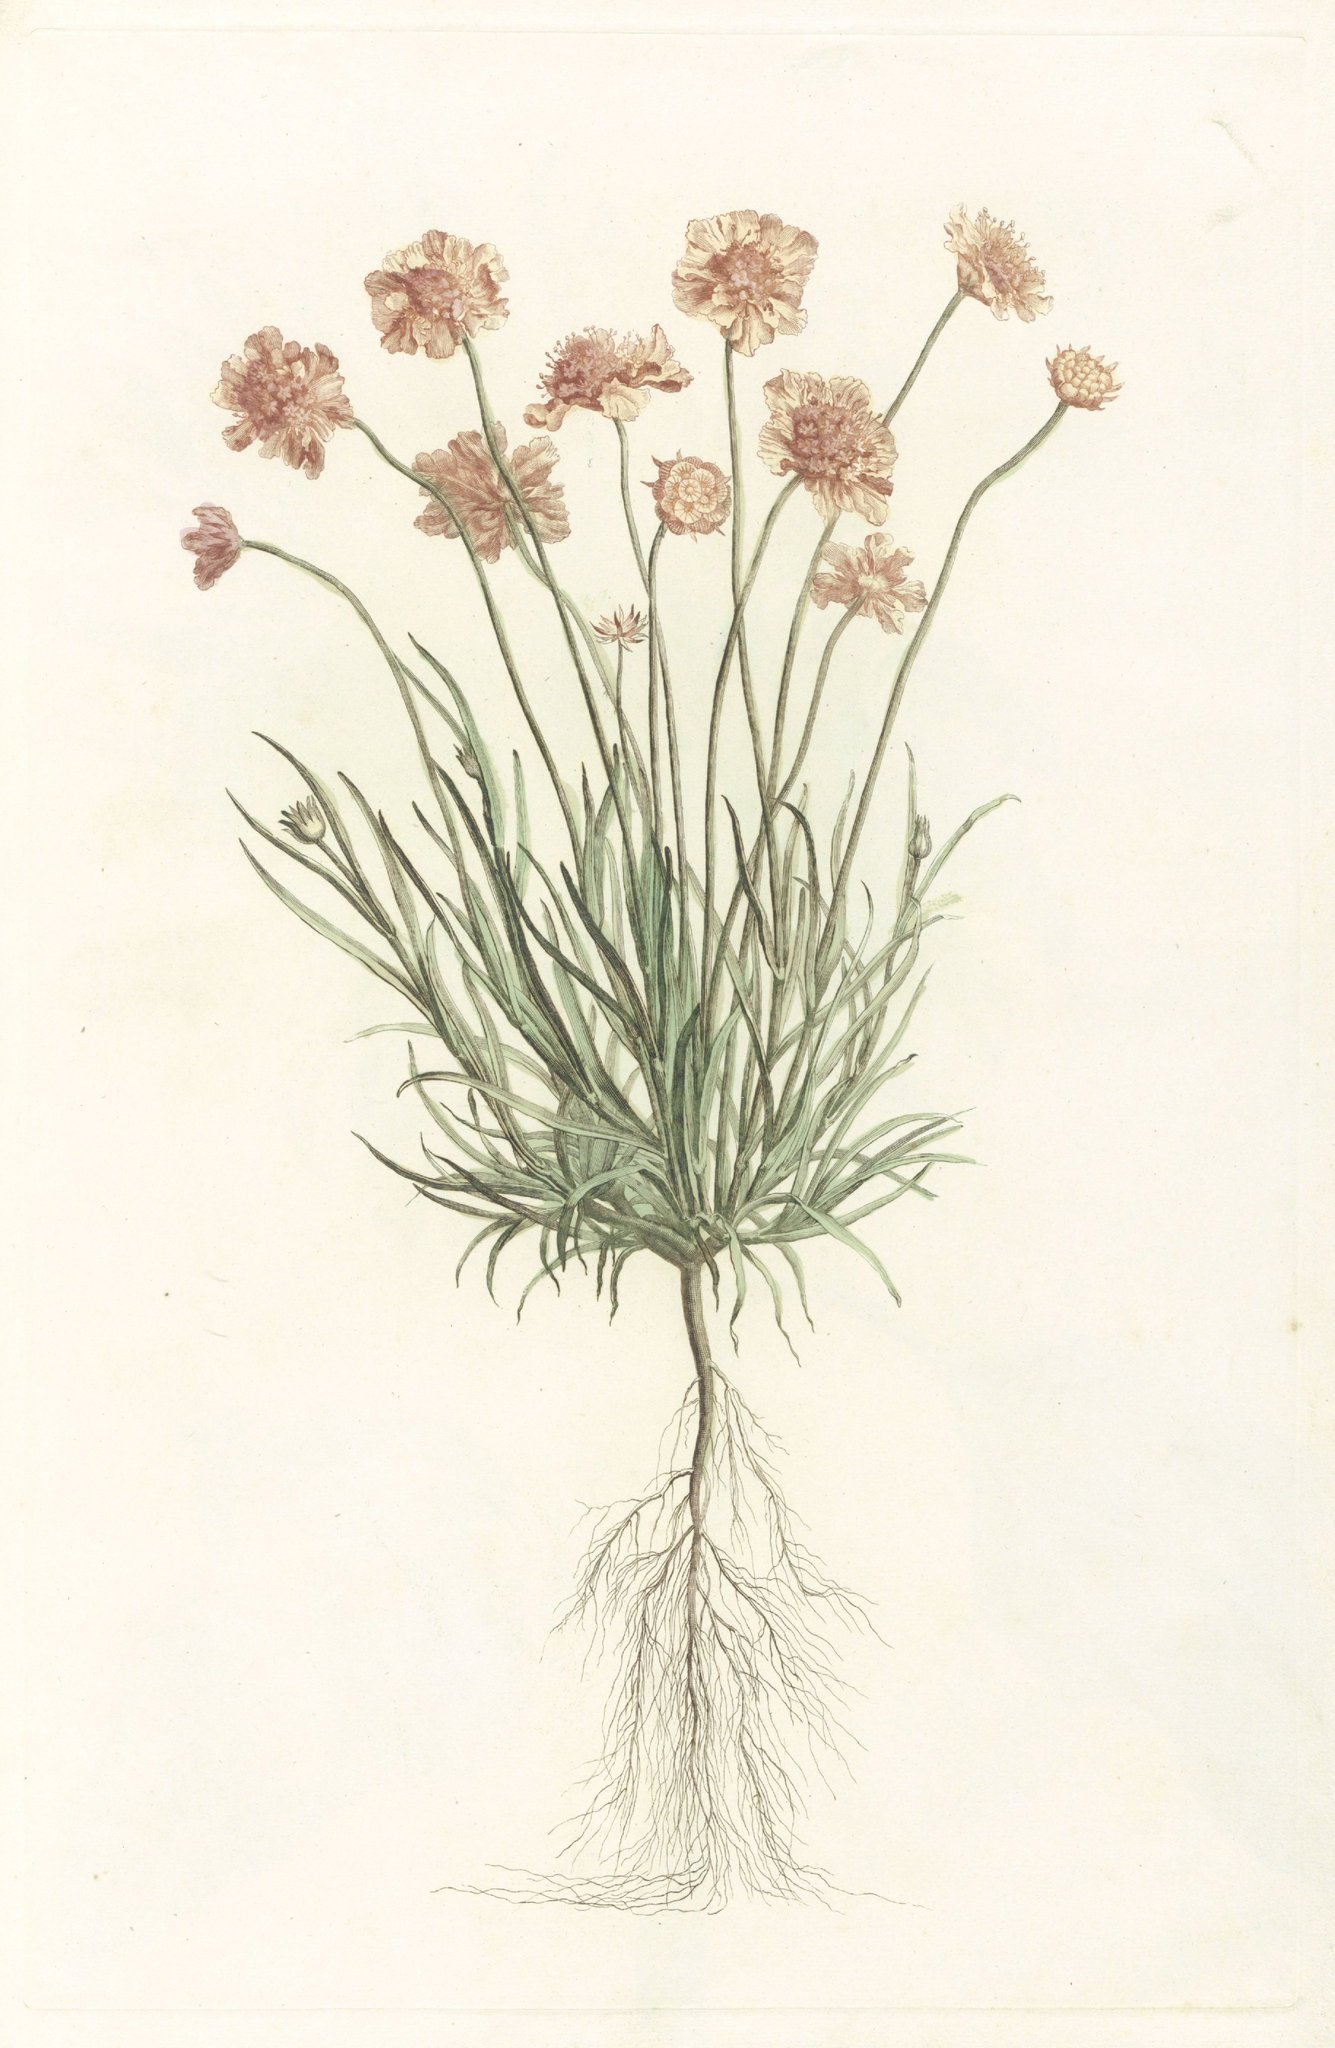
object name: album leaf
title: Scabiosa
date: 1688-1698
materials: paper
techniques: printing, engraving, hand coloring, lithography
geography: netherlands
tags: flowers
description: De plant Scabiosa met bloemen en wortels. Deze prent maakt deel uit van een album.